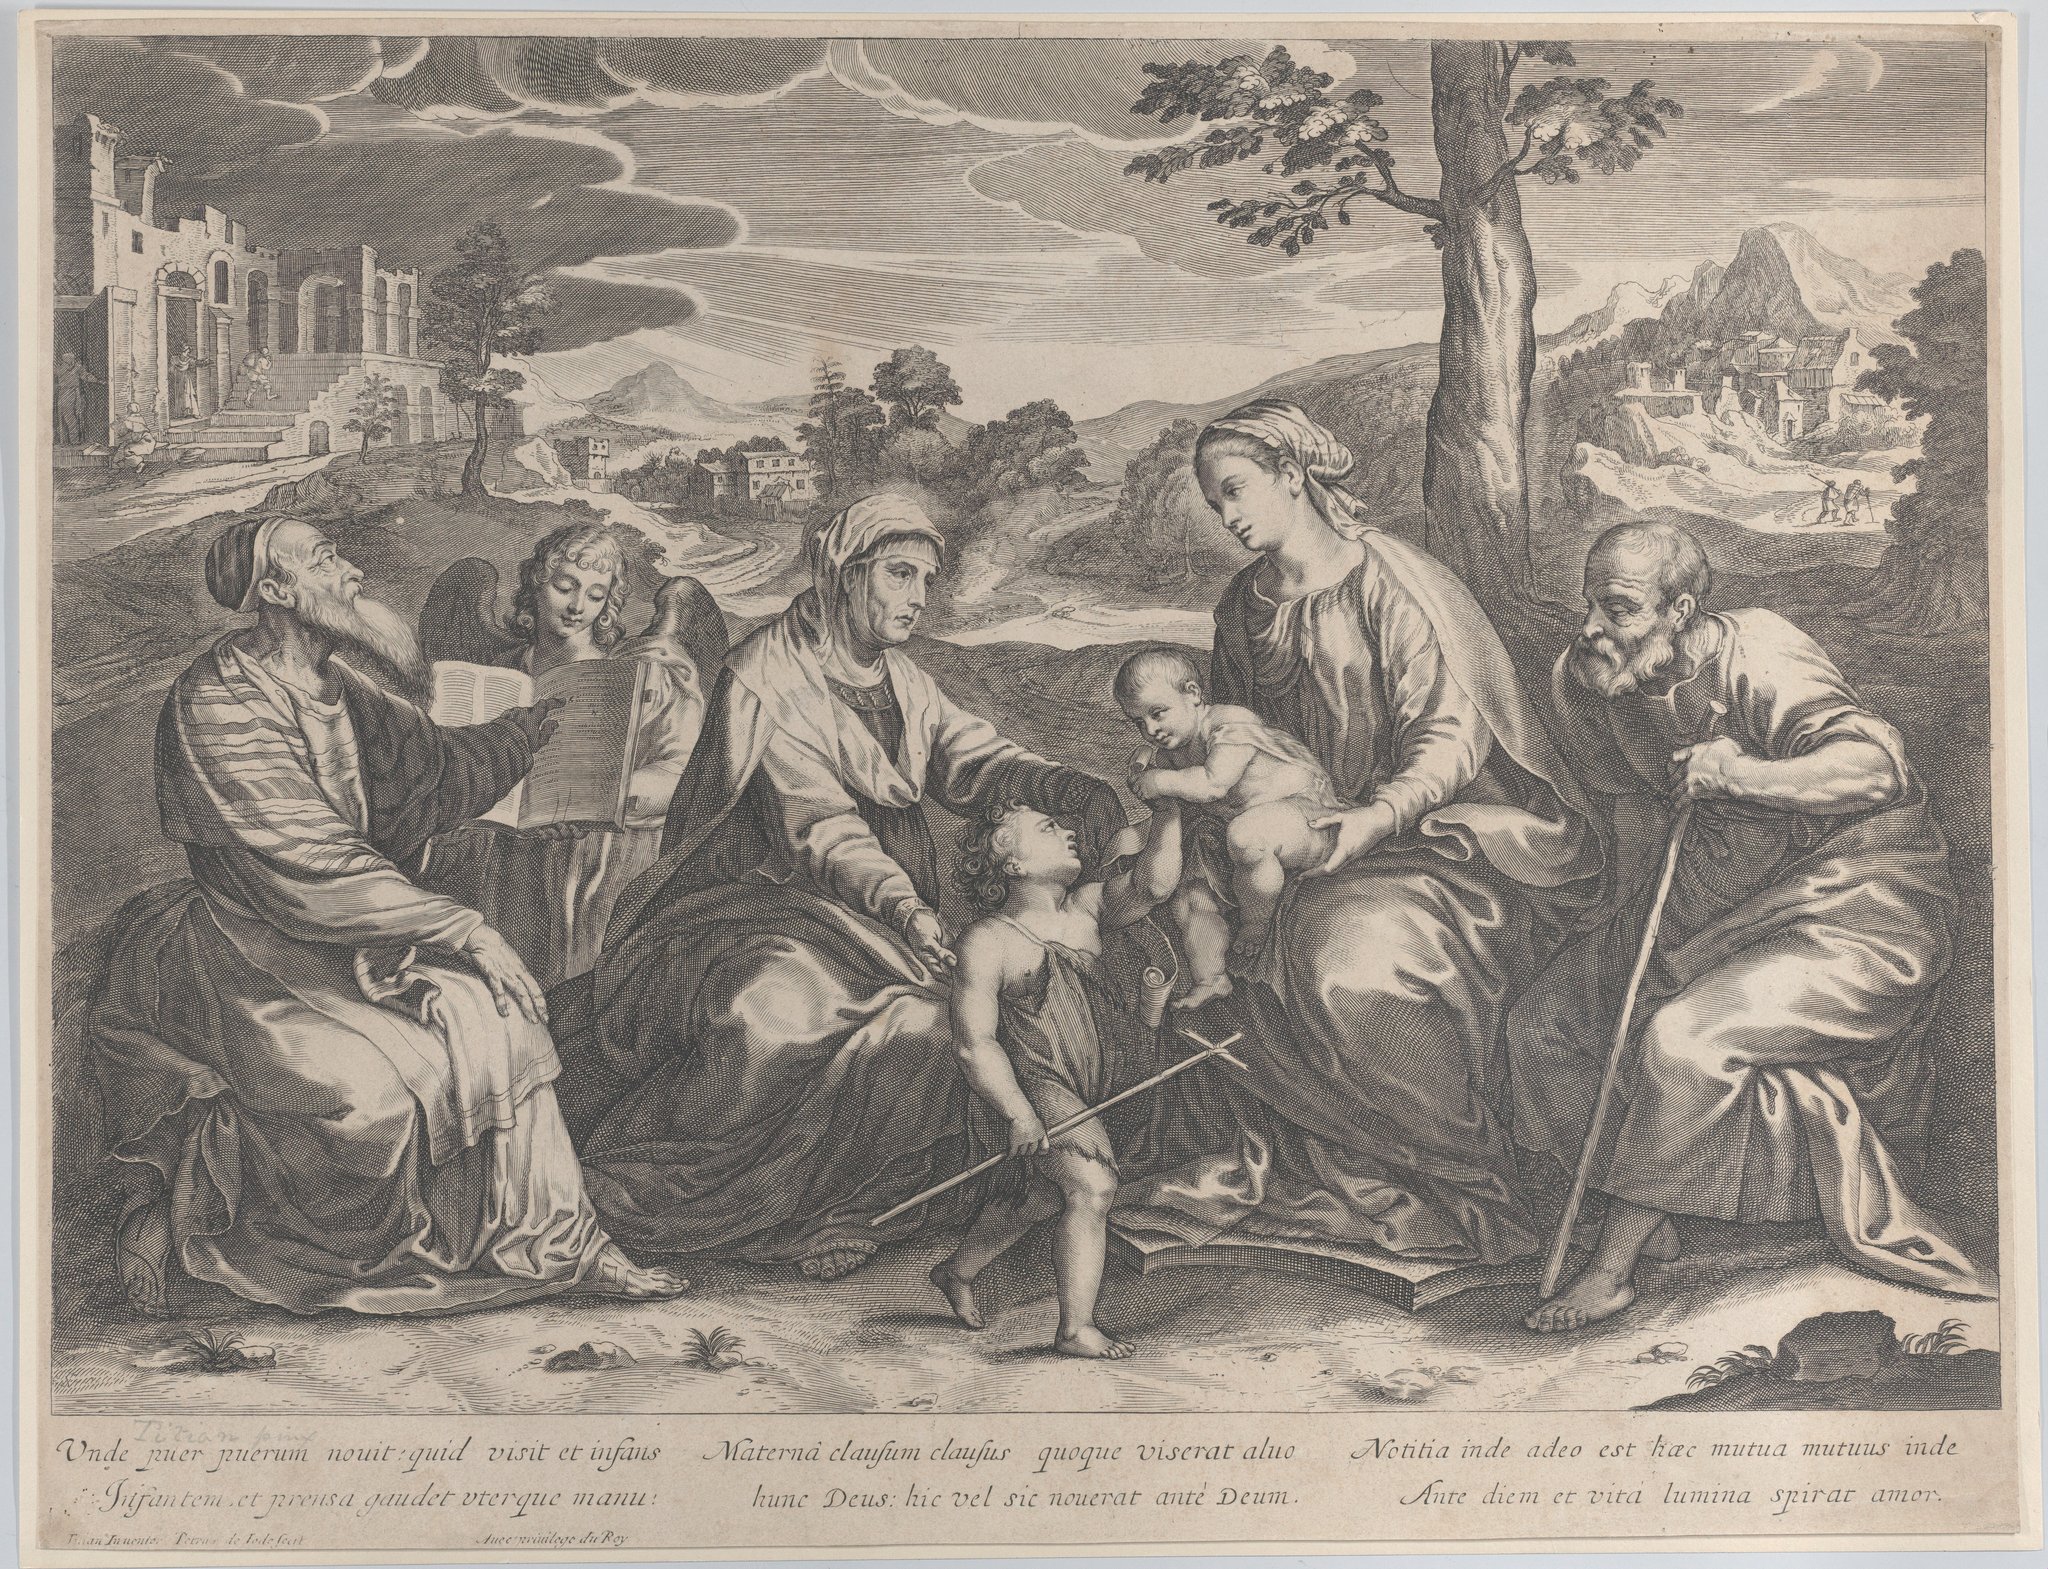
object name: print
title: The Holy Family at right, with the infant Saint John the Baptist, Elizabeth, Zacharias, and an angel at left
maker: pieter de jode (ii)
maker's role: artist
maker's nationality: flemish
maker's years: 1606-1674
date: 1631-1637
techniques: engraving